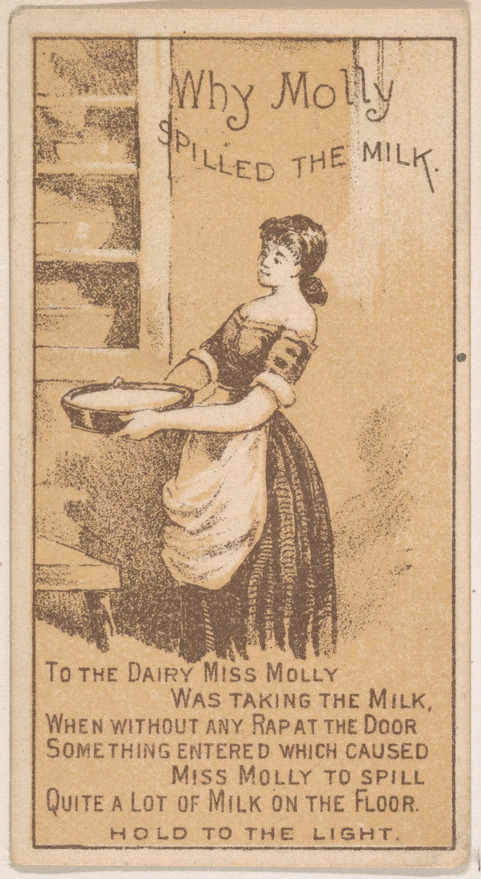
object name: print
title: Why Molly Spilled the Milk, from the Magic Changing Cards series (N223) issued by Kinney Tobacco Company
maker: kinney brothers tobacco company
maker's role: publisher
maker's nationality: american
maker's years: 1869-2011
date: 1889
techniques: color lithograph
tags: women